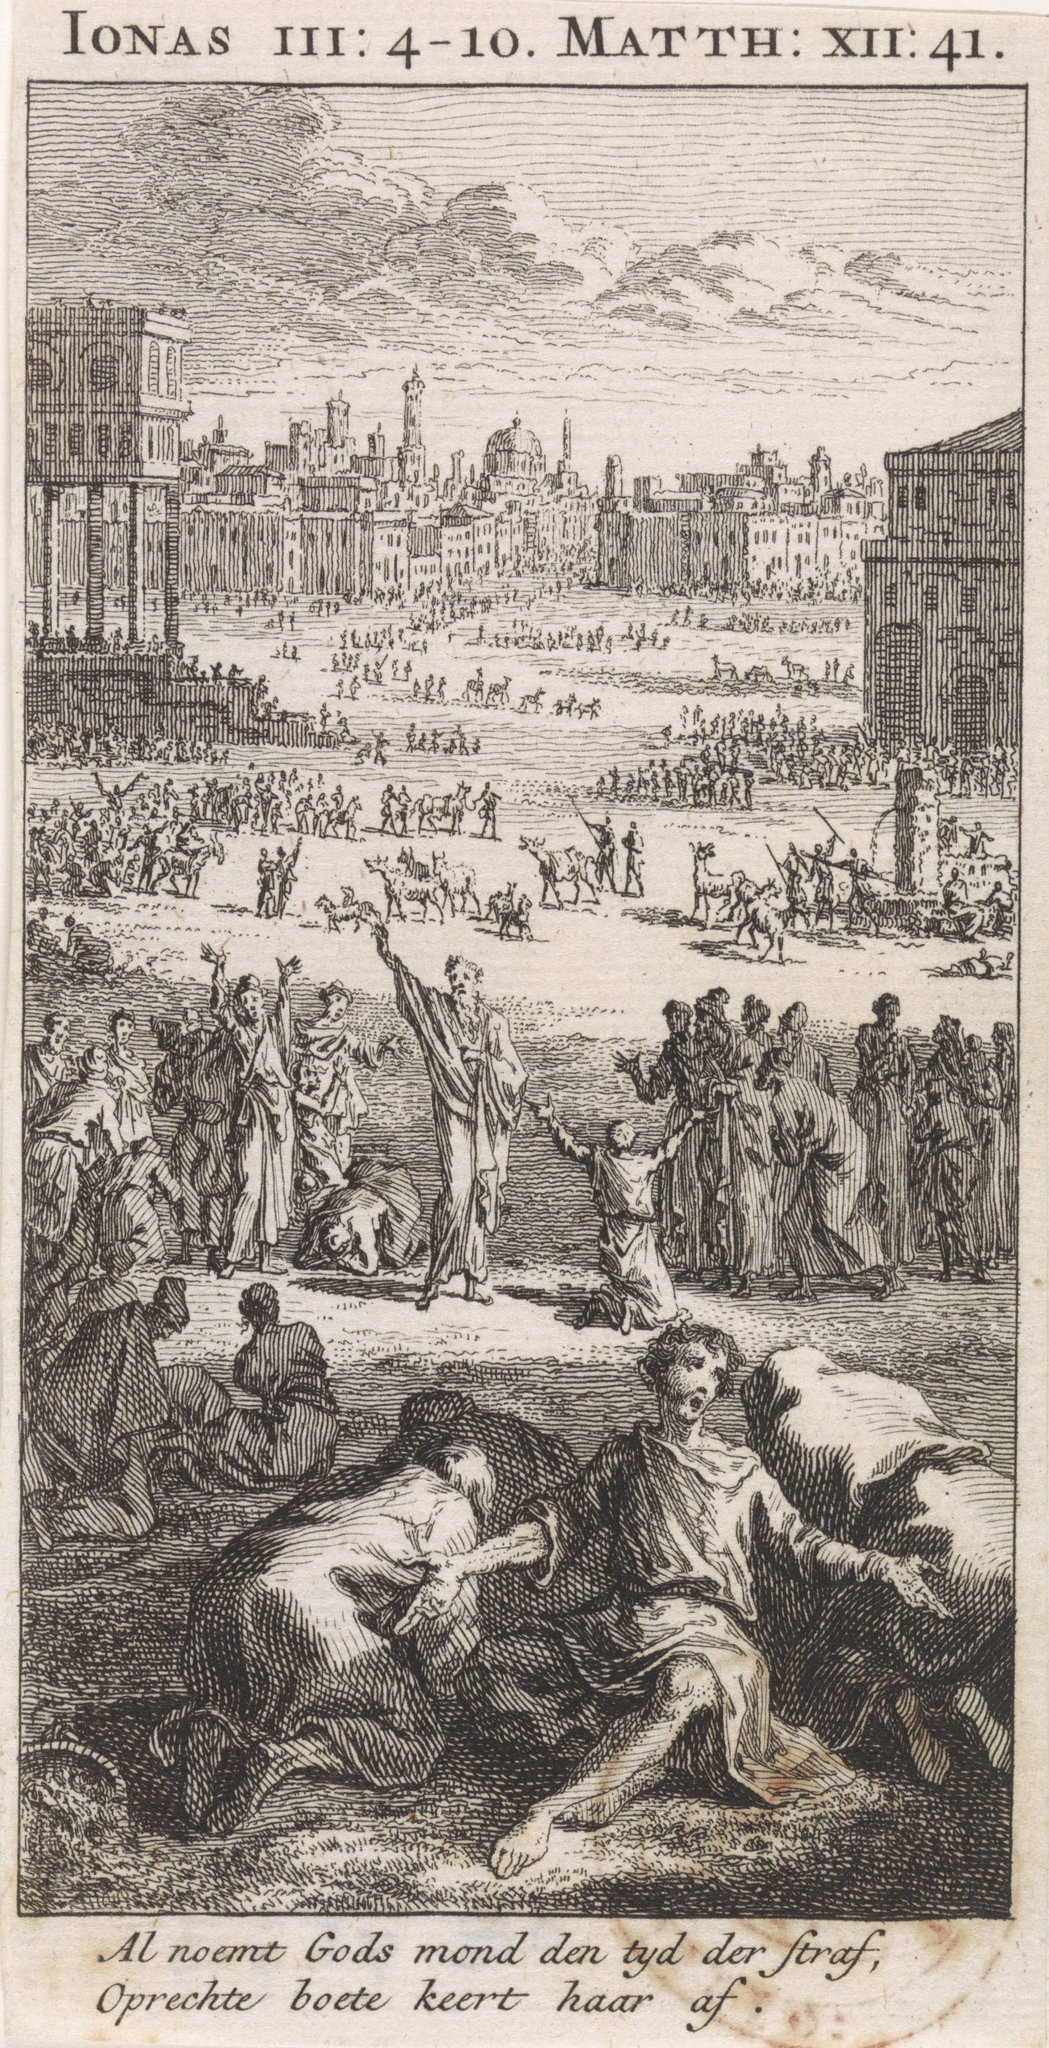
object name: print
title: Jona voorspelt de ondergang van Nineve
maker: jan luyken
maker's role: draughtsman, print maker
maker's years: 1649-1712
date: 1712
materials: paper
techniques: etching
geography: amsterdam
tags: when jonah arrives in the city of nineveh he foretells its destruction in forty days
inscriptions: collector's mark: Lugt 240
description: Variant op illustratie voor: Luyken, Jan. Bybel printen. Amsterdam: Pieter Arentsz. II (wed.) en Cornelis van der Sys, 1712, p. 17.